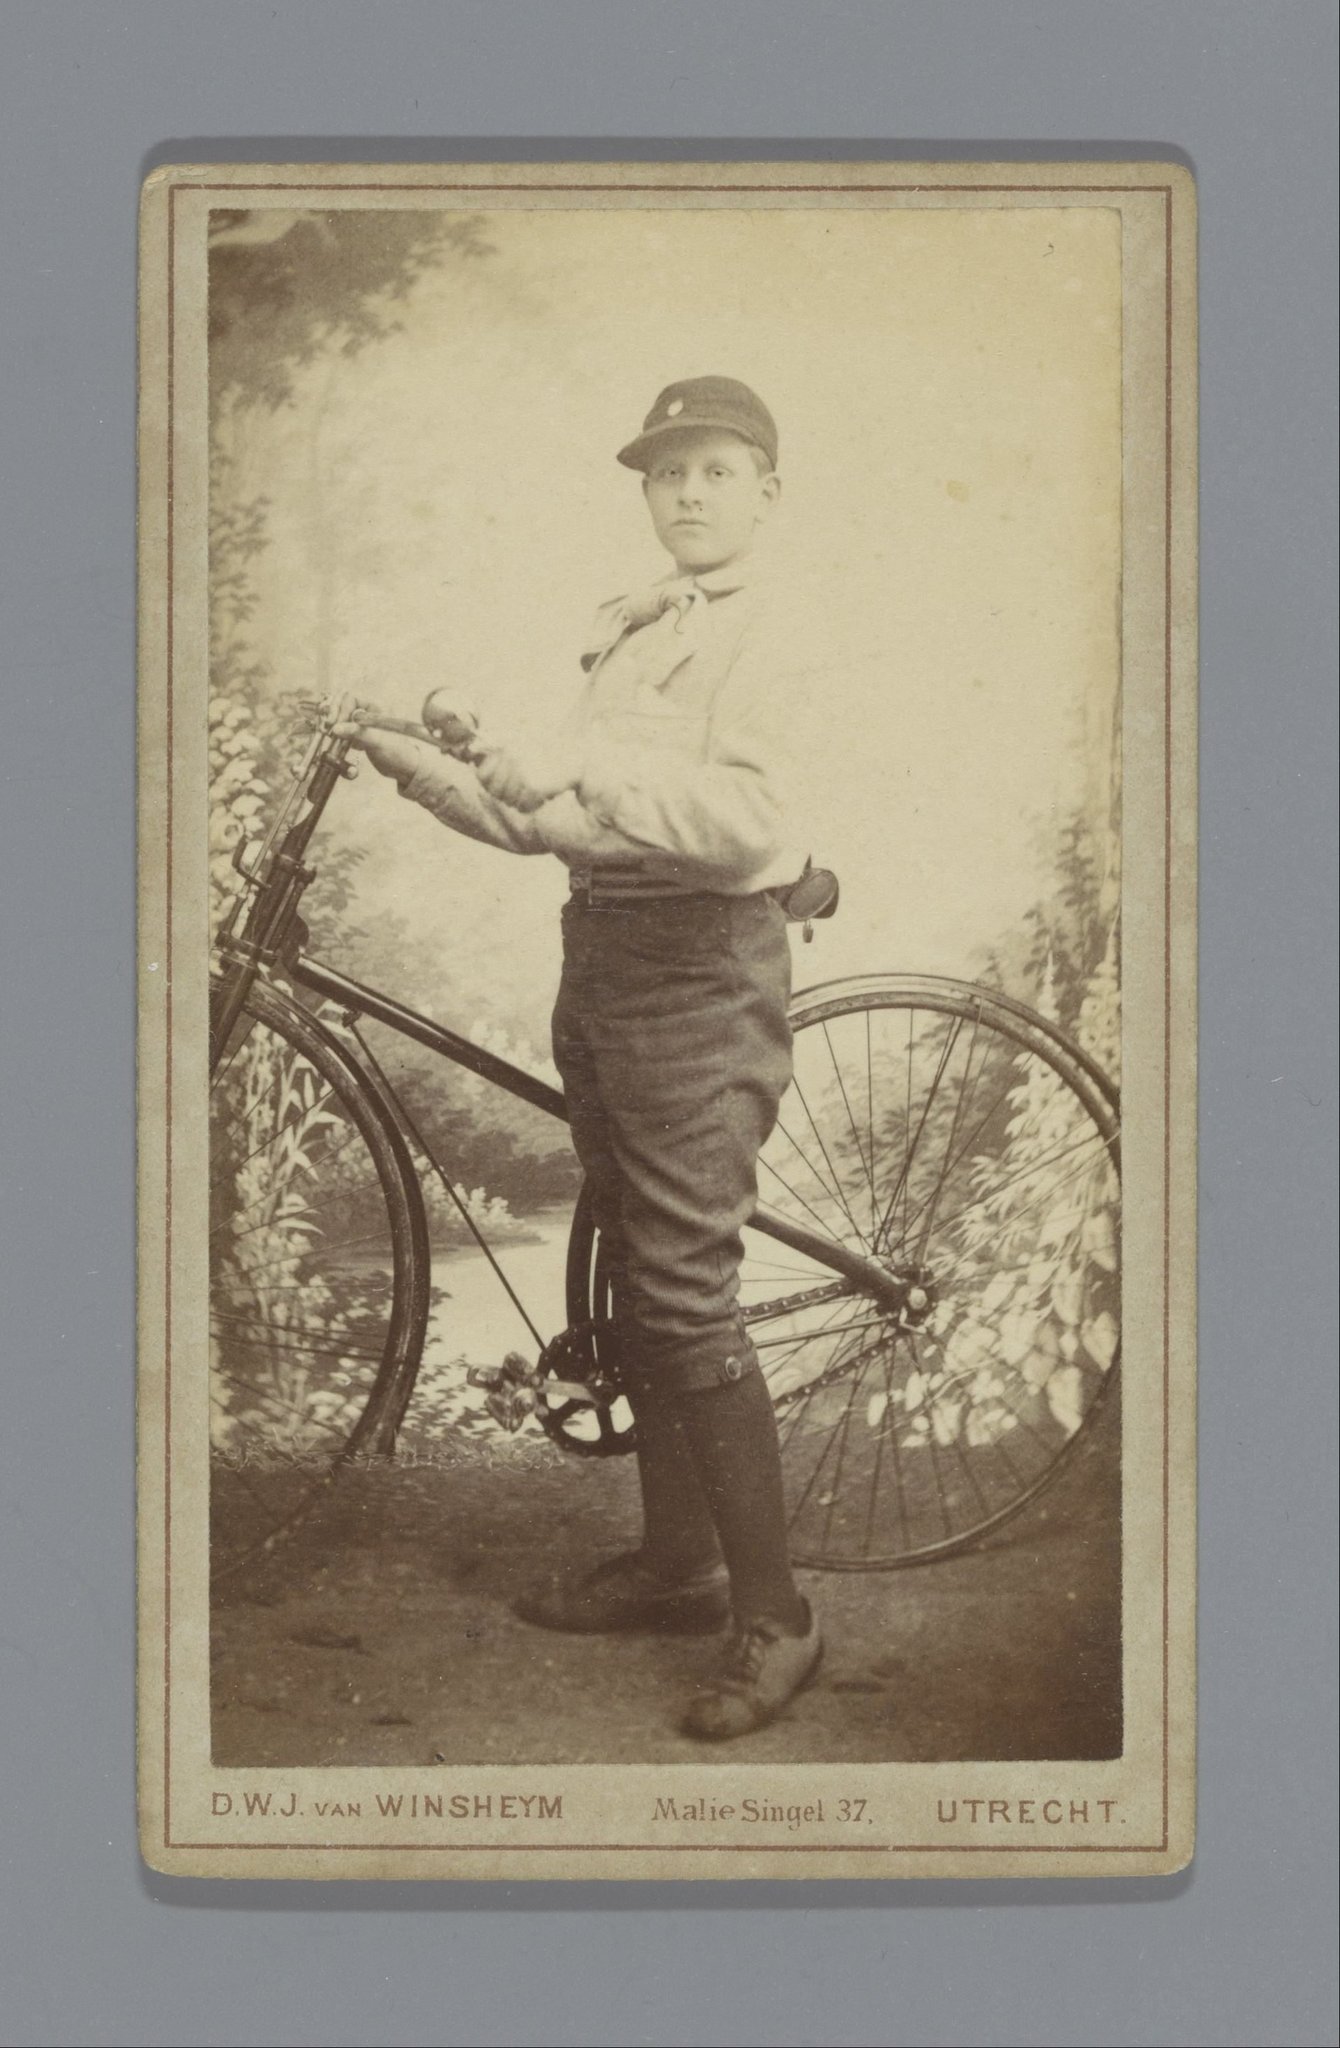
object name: carte de visite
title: Portret van een onbekende jongen (vermoedelijk) in padvindersuniform met een fiets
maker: d.w.j. van winsheijm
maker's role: fotograaf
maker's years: 1858-1918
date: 1878-1895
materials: cardboard, photographic support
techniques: albumen print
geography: utrecht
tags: youth, adolescent, bicycle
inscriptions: inscription: ‘Photographie Instantanée D.W.J. van Winsheijm Peintre et Photographe artiste Maliesingel 37 b.h. Oosterspoor heraldisch Kunstatelier Specialiteit in Vergrootingen (...) in oliverf en Pastel.’